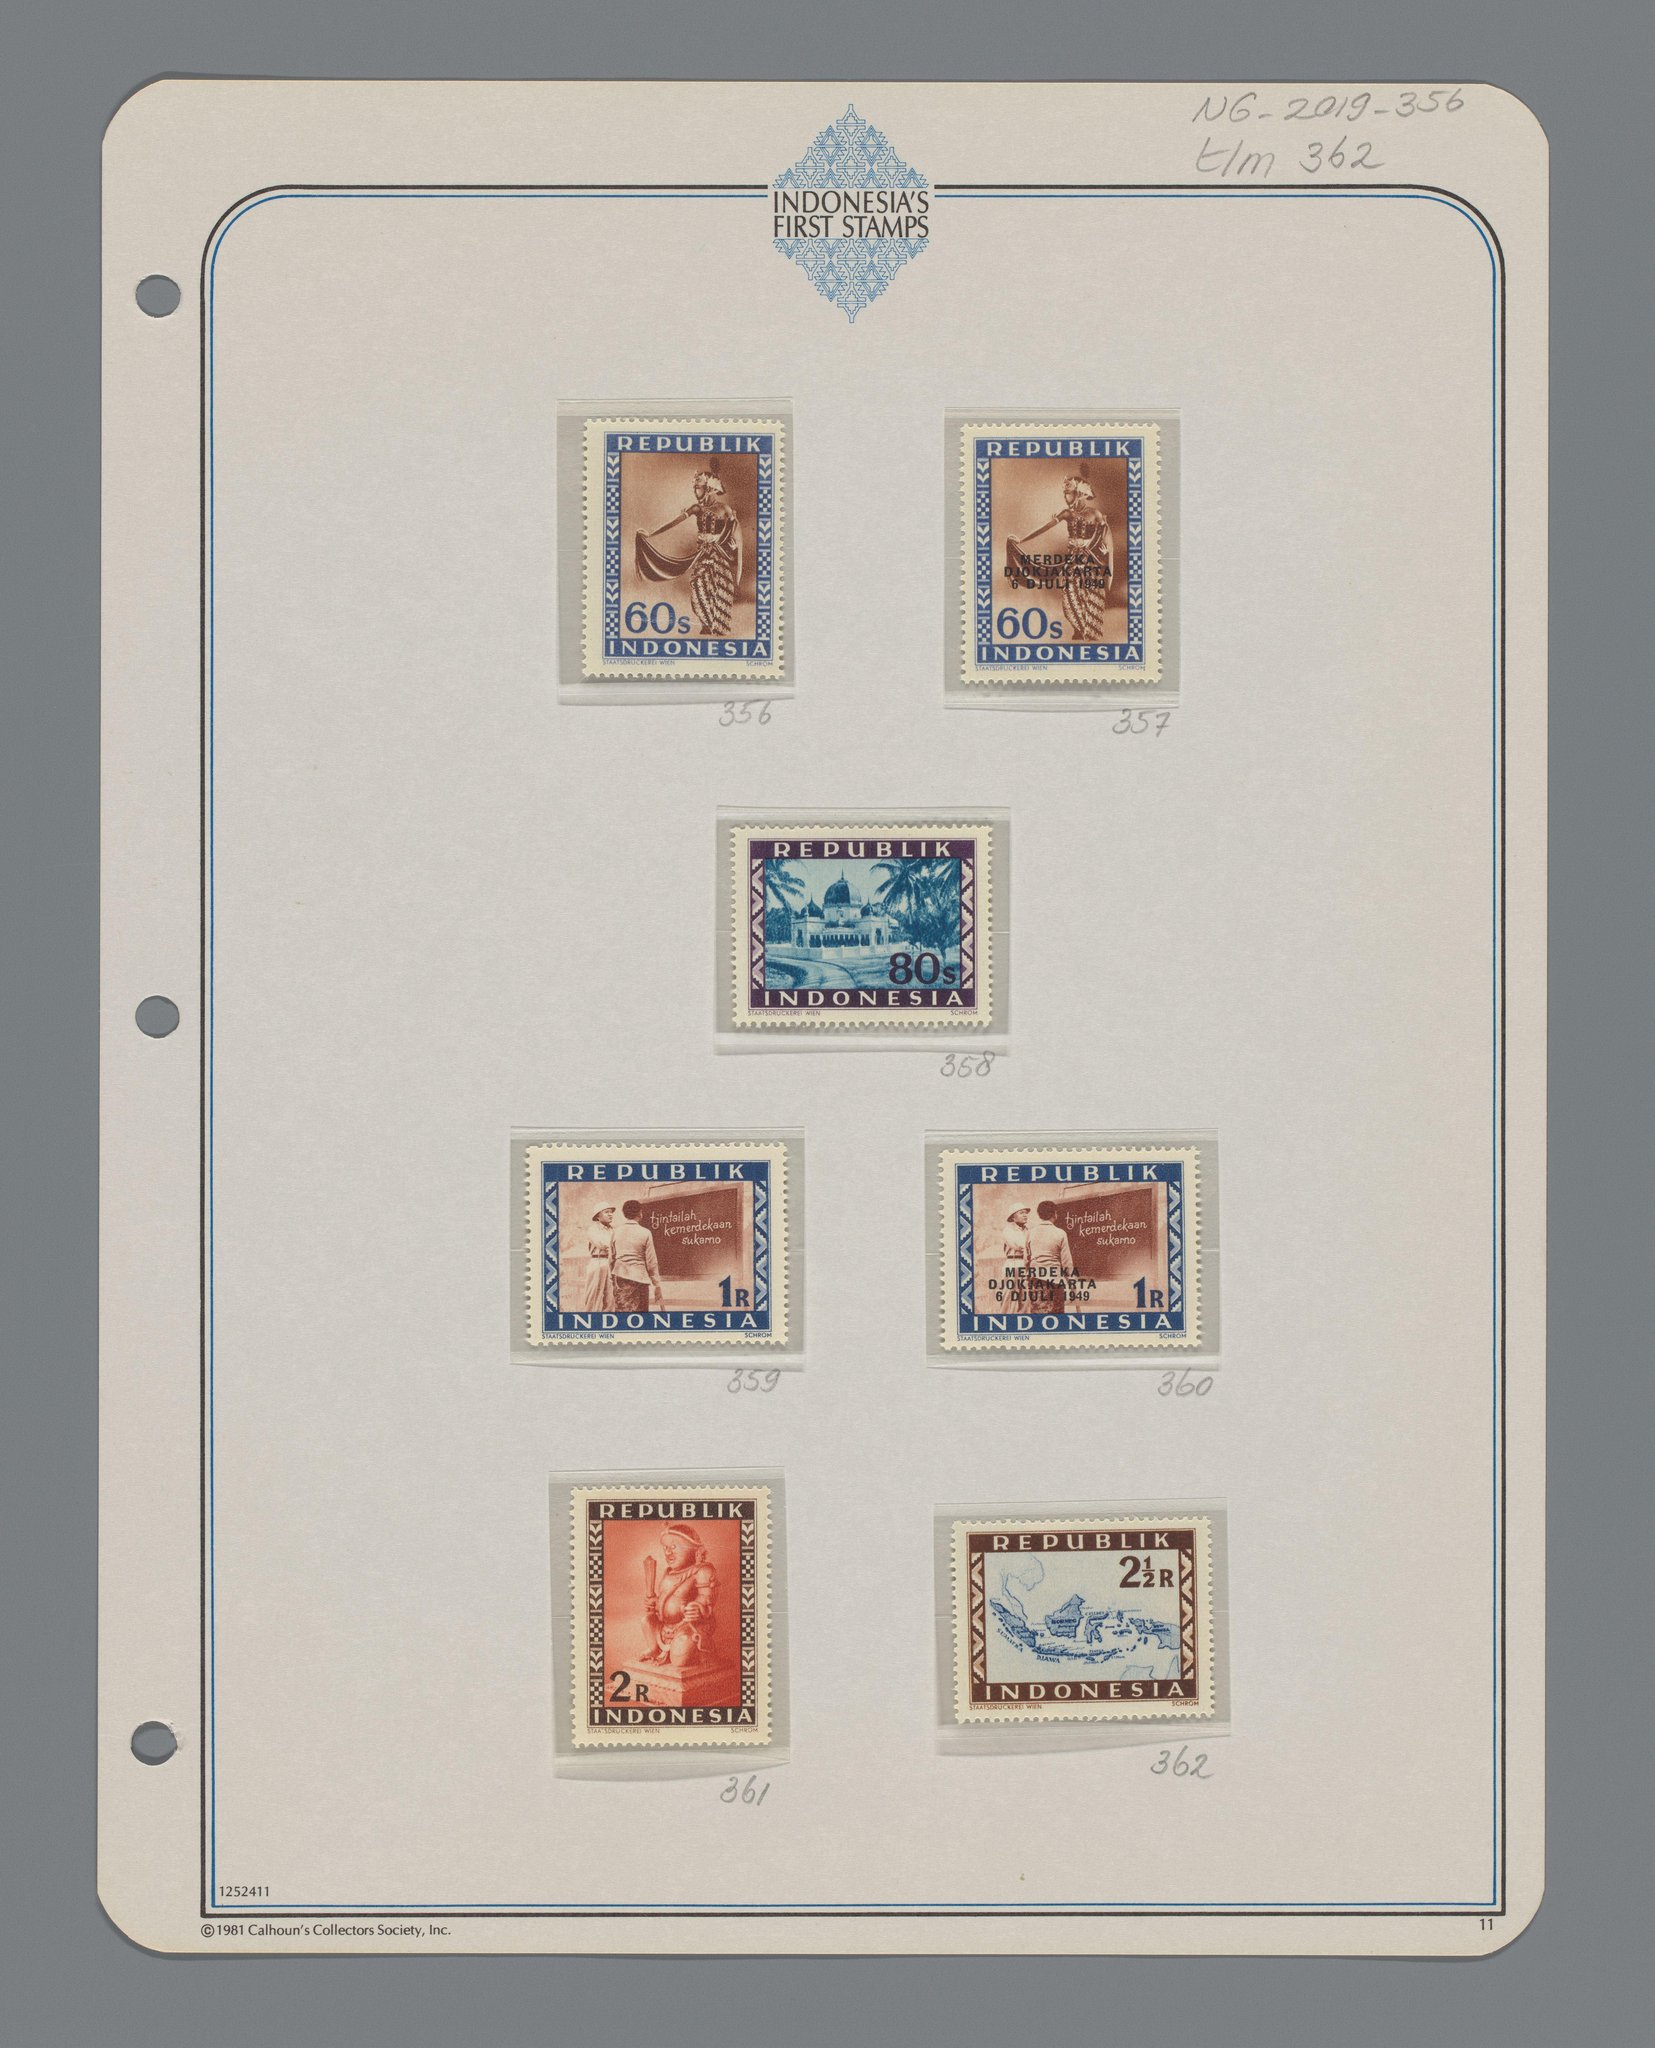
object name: postage stamp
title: Postzegel Republik Indonesia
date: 1949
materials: paper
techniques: photoaquatint, engraving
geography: vienna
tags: indonesia